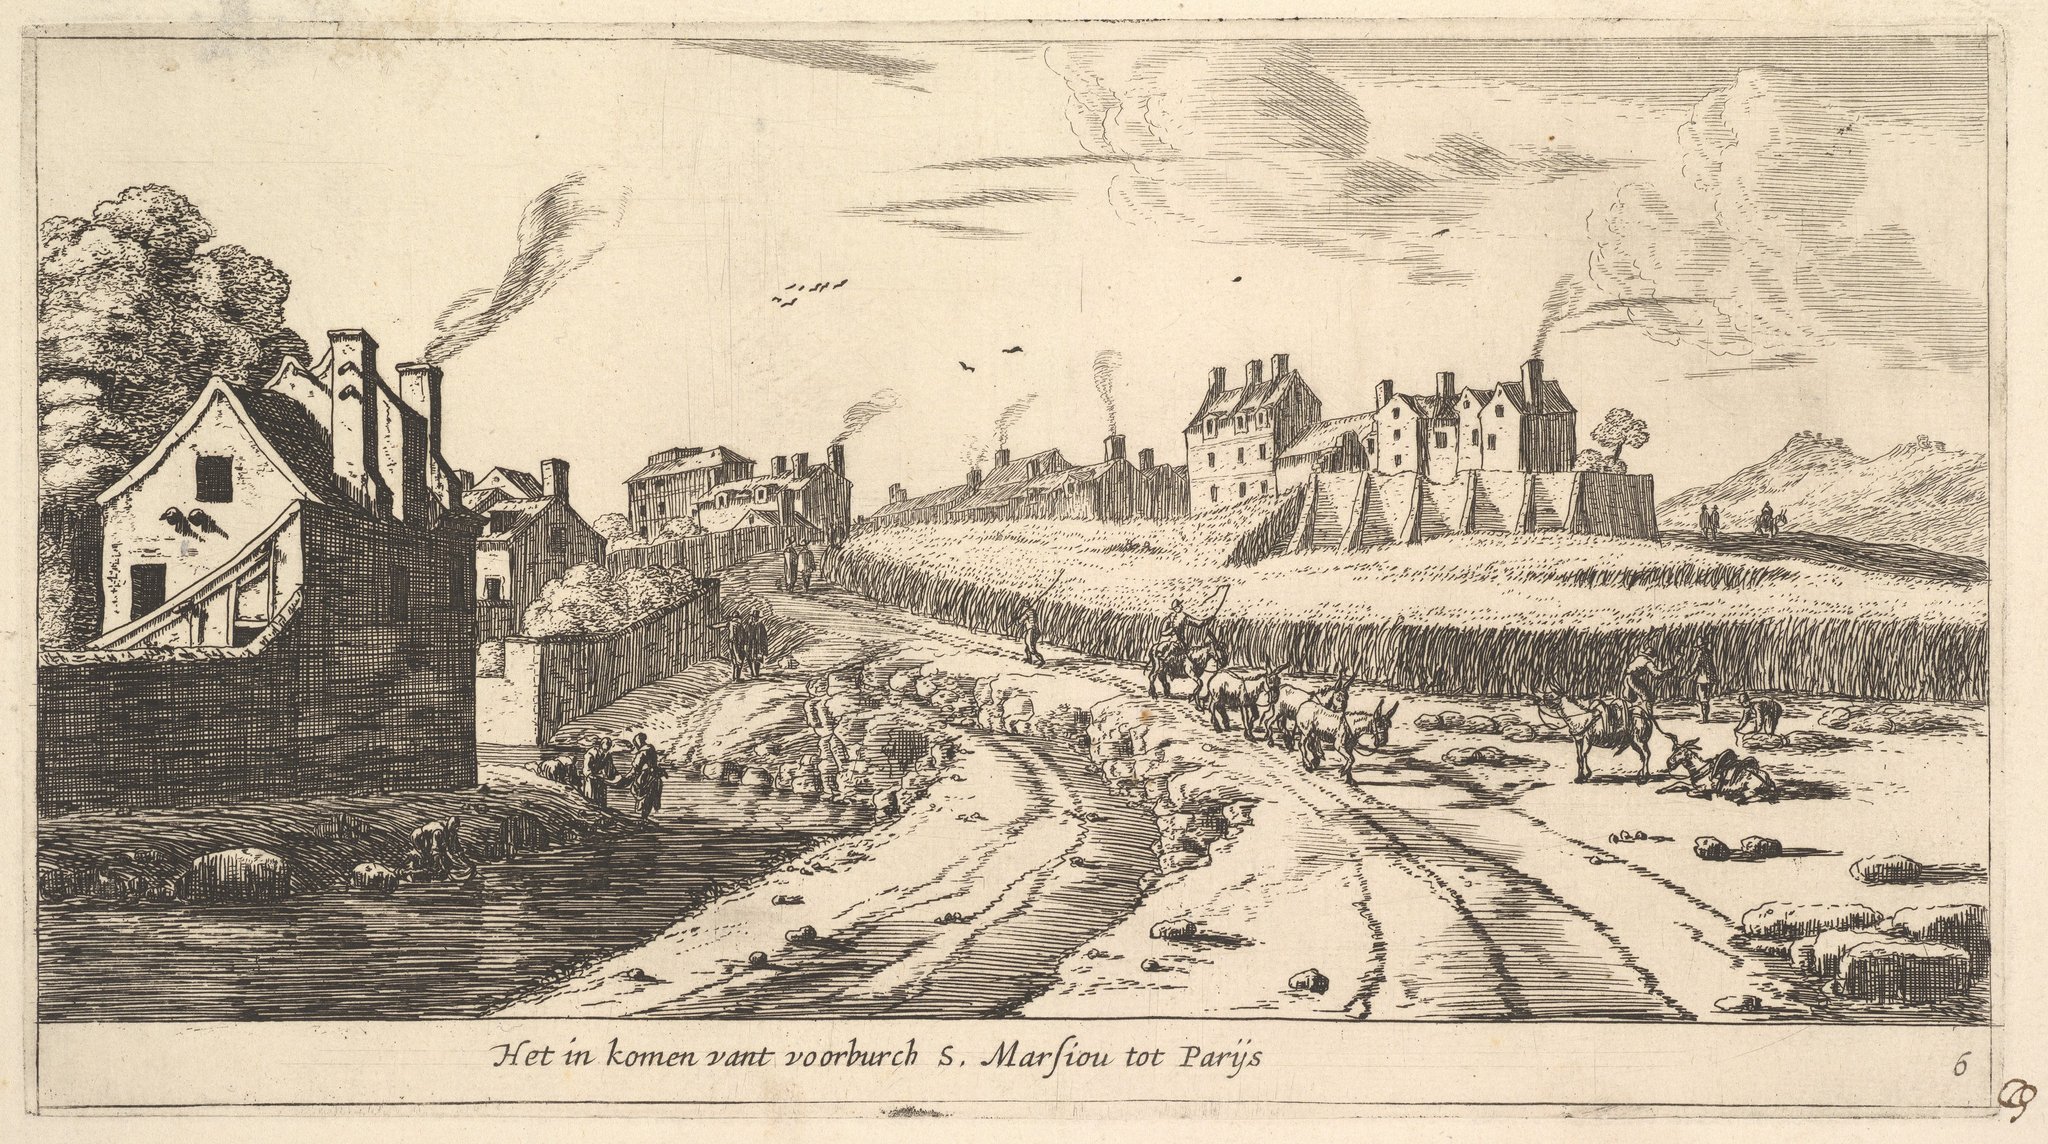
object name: print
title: Entrance to the Suburb of Saint Marceau near Paris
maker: reinier nooms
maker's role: artist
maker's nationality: dutch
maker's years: 1623-1664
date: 1601-1700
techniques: etching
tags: buildings,roads,landscapes,paris